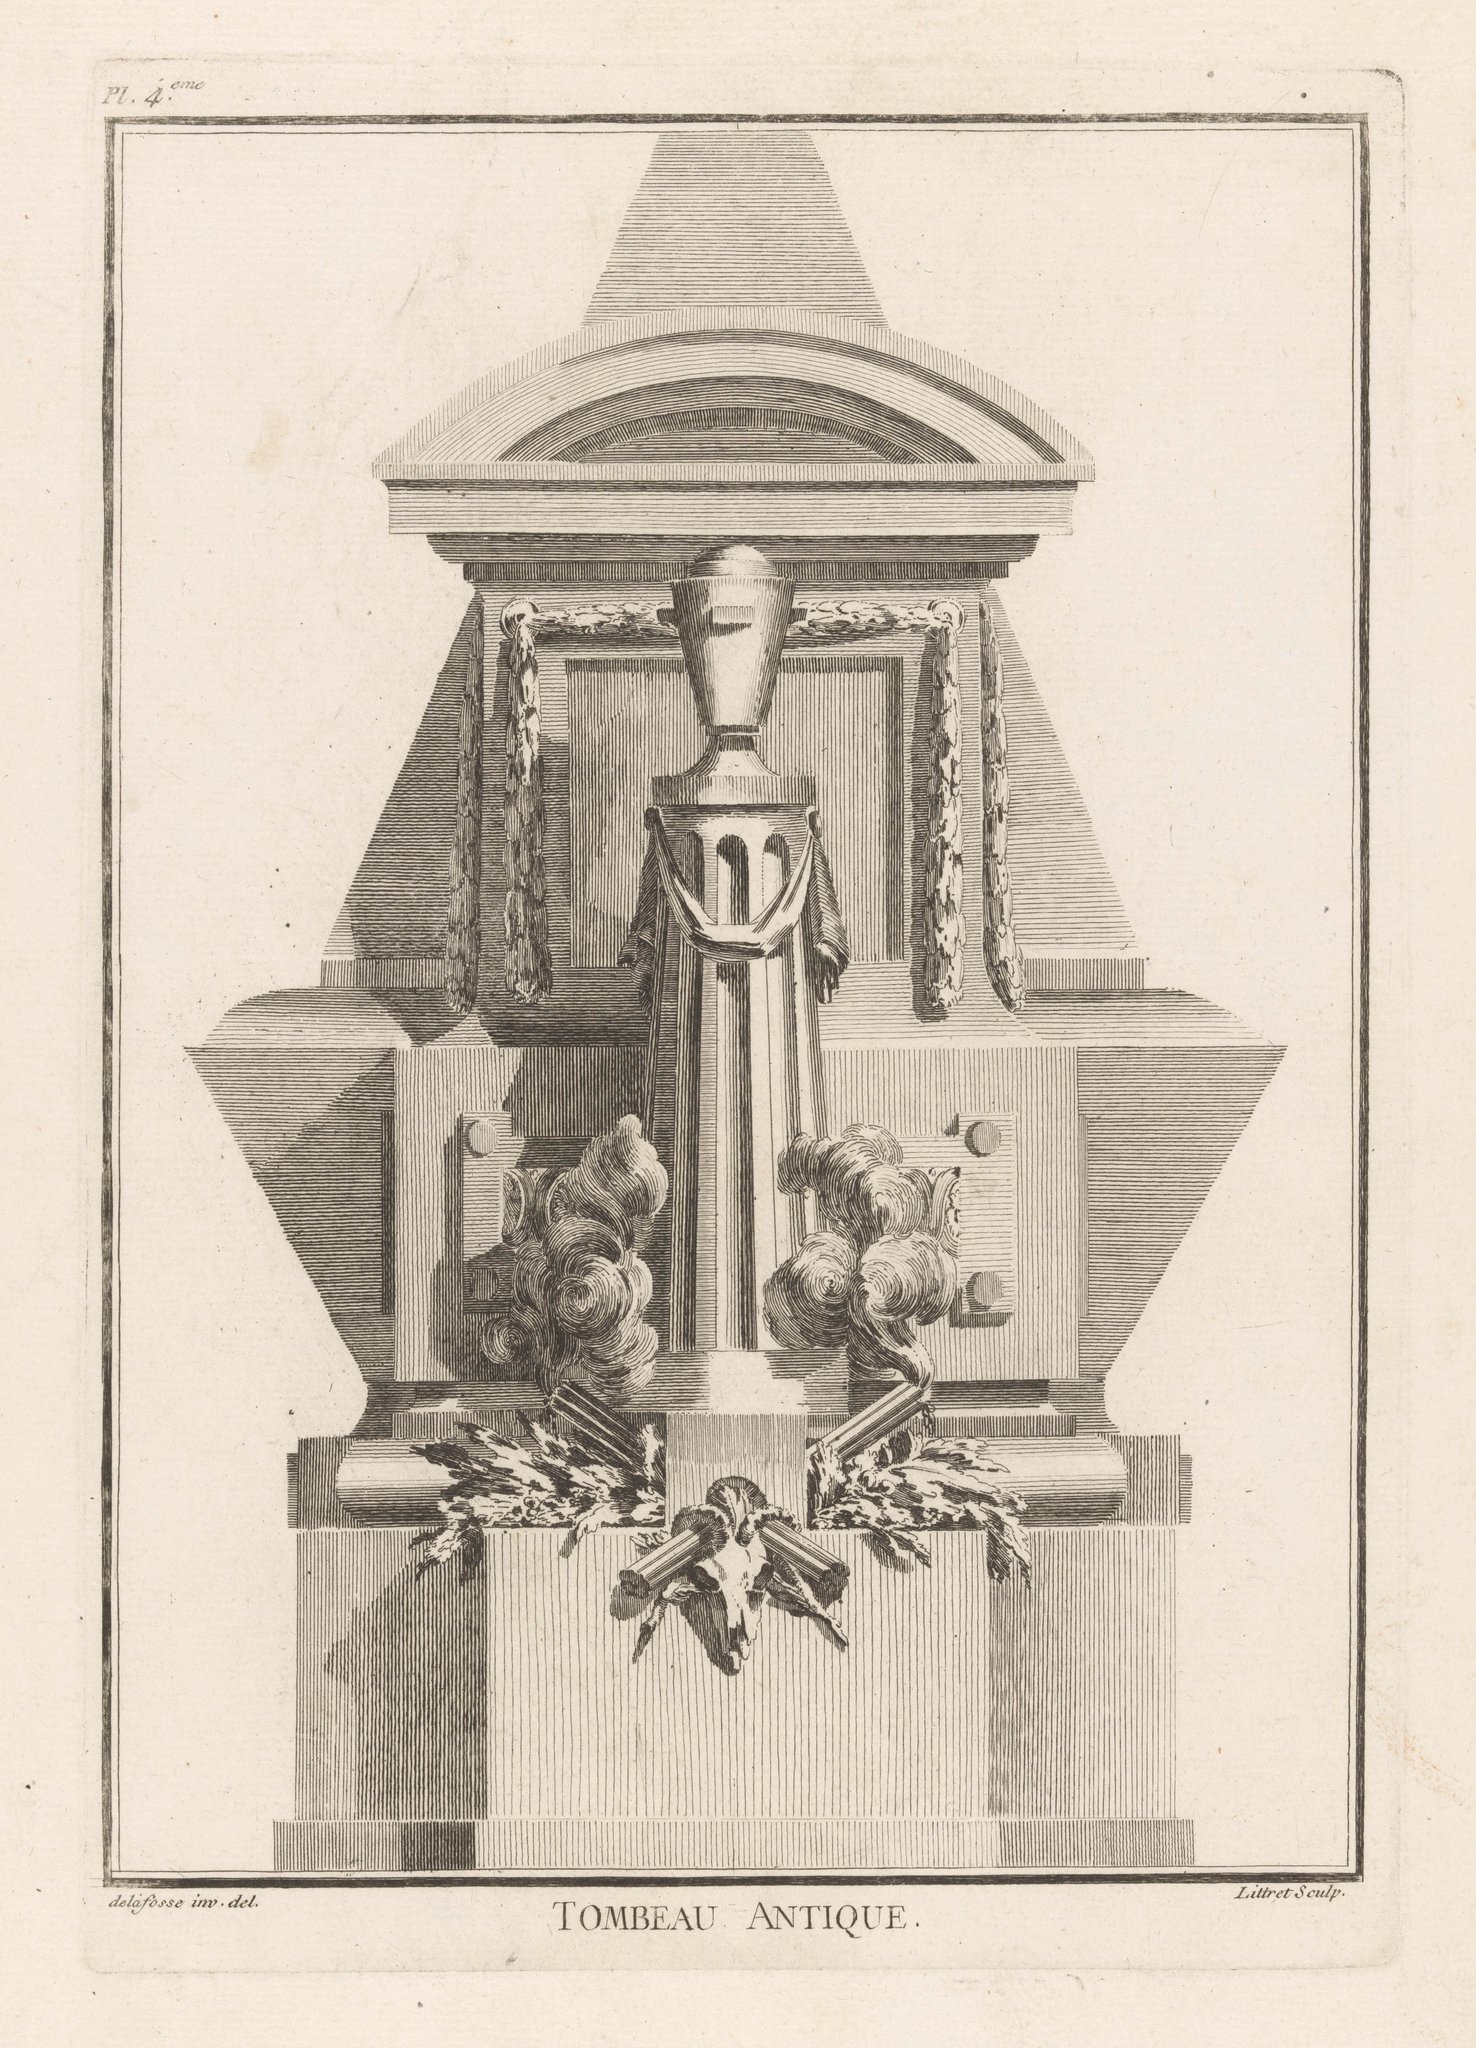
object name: print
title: IIe Volume De l'Oeuvre de J. Ch. Delafosse (...)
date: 1771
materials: paper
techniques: engraving, etching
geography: paris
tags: torch, vase ~ ornament, grave, tomb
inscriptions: collector's mark: Lugt 2760, collector's mark: Lugt 2228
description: Een tombe met een bucranium, fakkels en een vaas op een voetstuk.